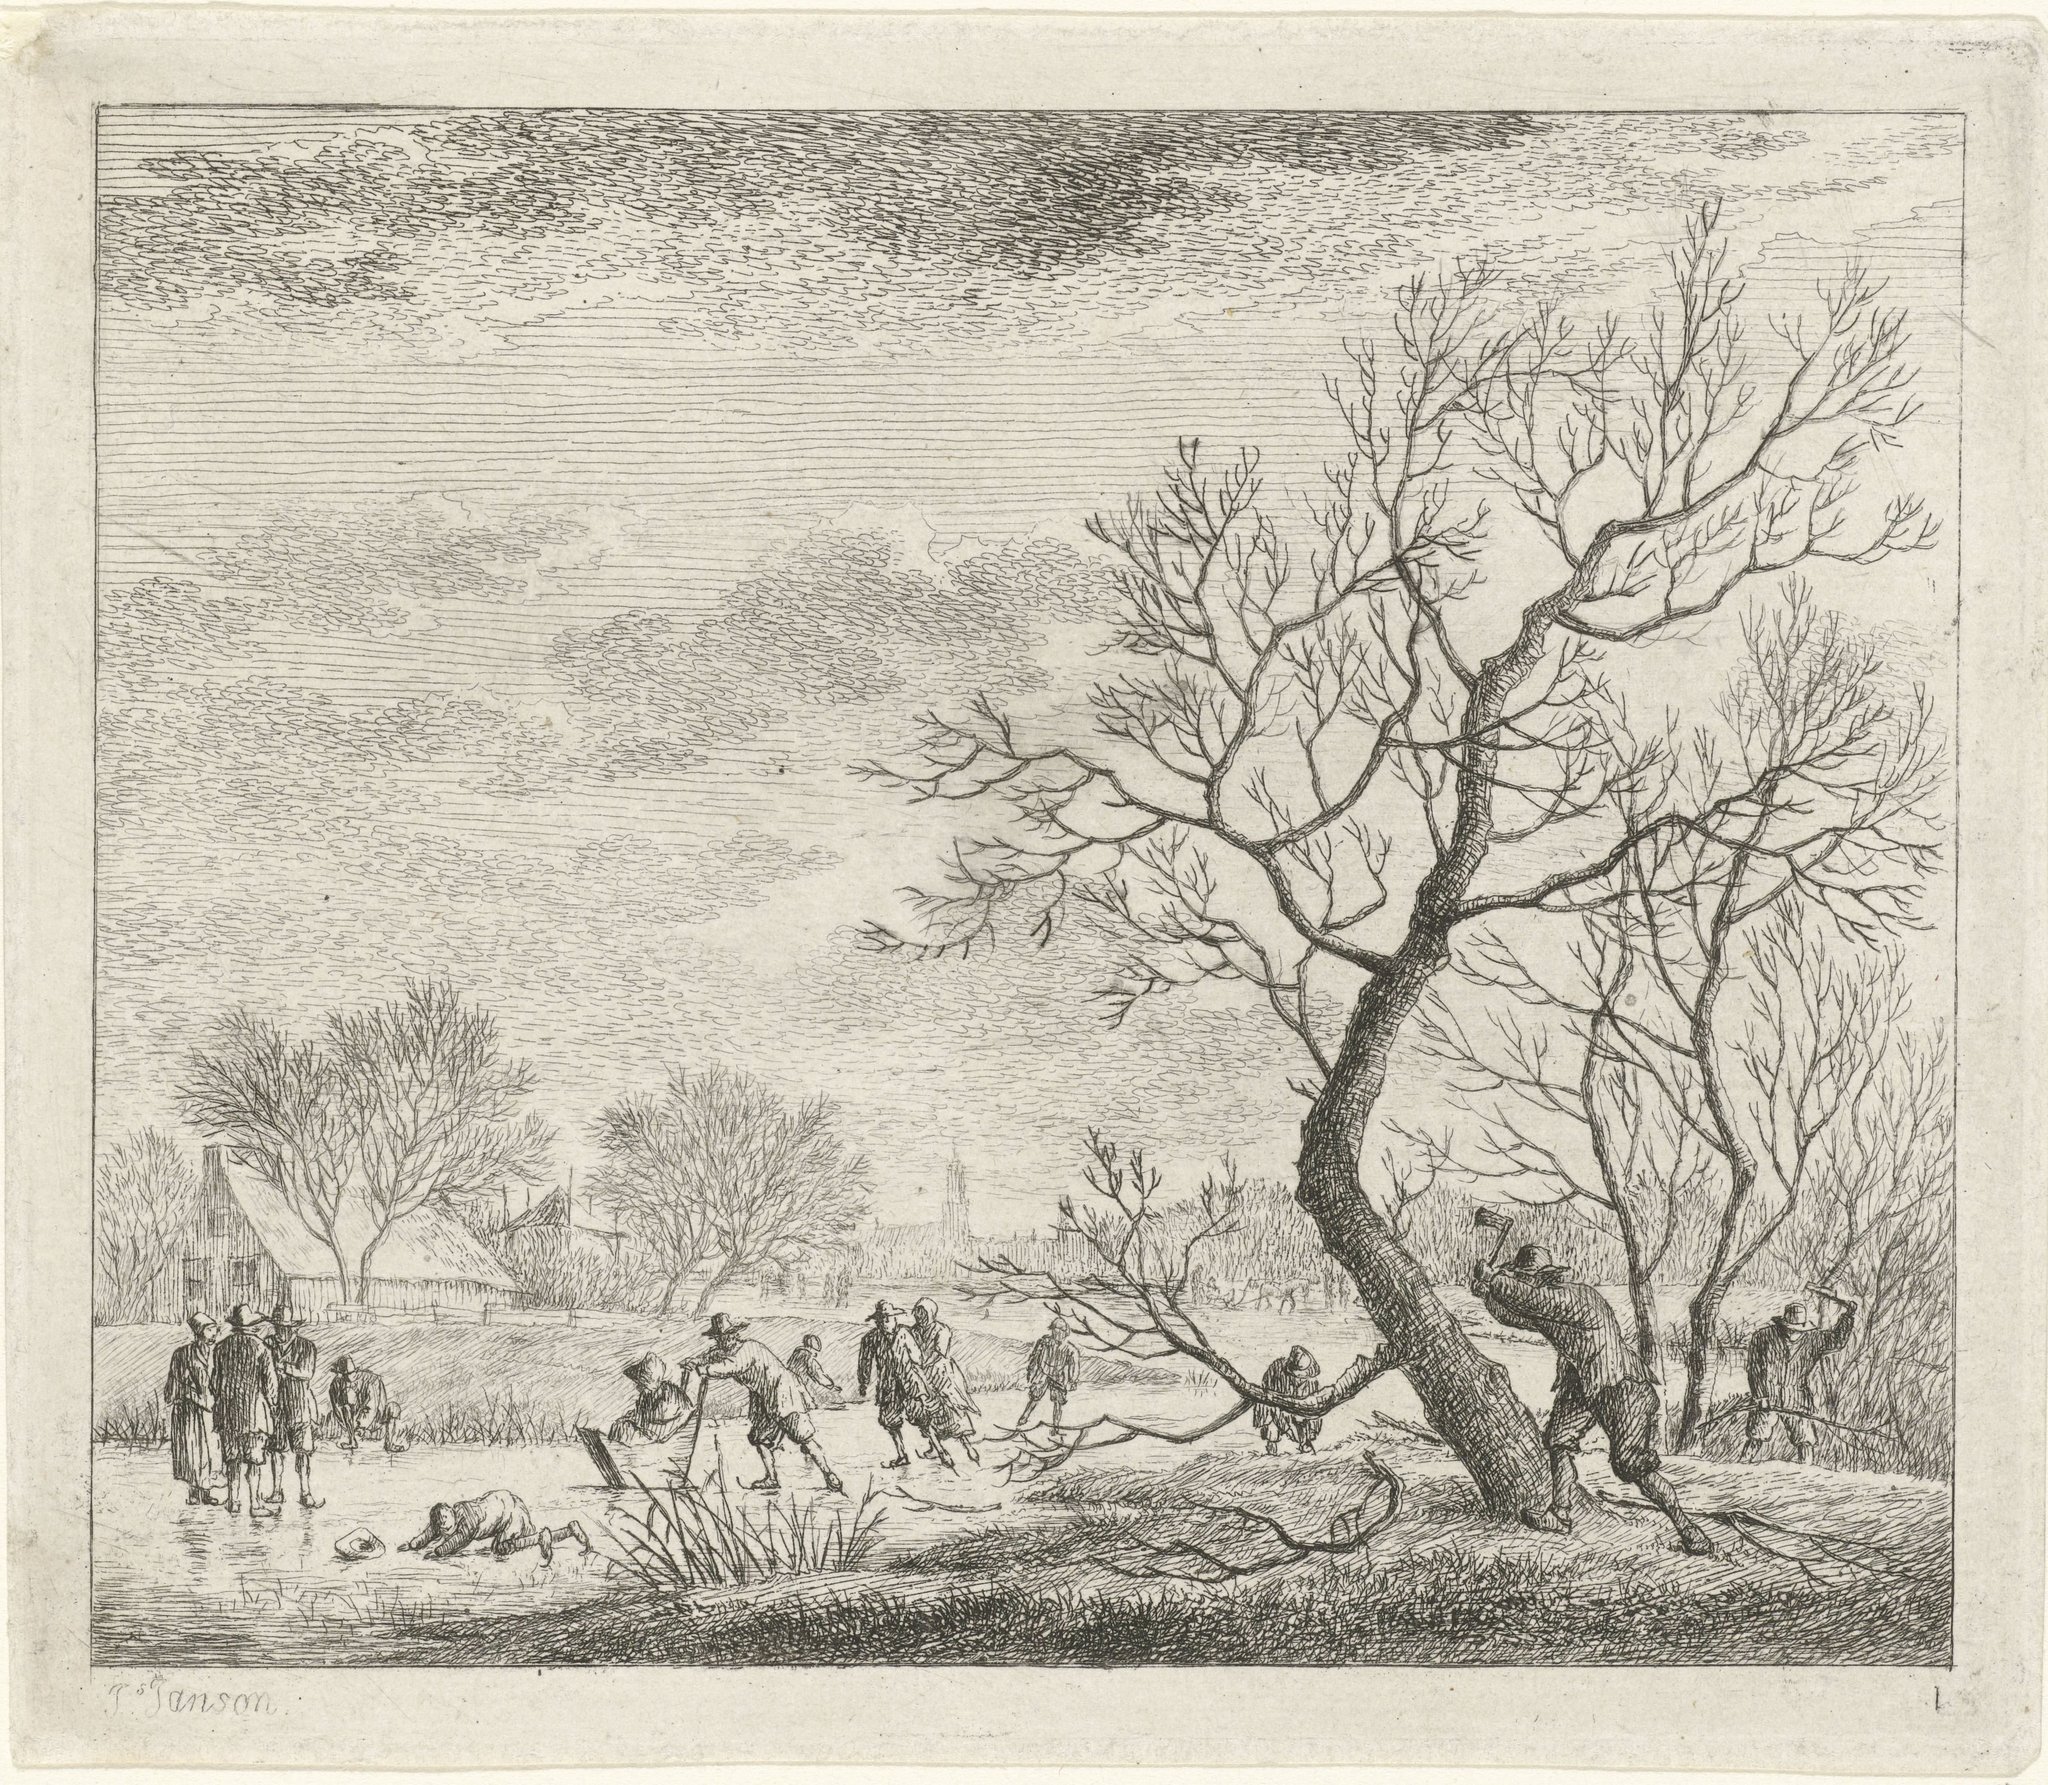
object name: print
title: Januari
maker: johannes janson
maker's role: draughtsman, painter, print maker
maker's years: 1729-1784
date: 1783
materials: paper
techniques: etching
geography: leiden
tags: winter landscape; landscape symbolizing winter (the four seasons of the year), landscape symbolizing january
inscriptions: collector's mark: Lugt 2228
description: Winterlandschap met schaatsers en rechts op de voorgrond een man met een bijl bij een boom. Op de achtergrond een dorp. Rechtsonder: 1. Tweede prent uit een serie van dertien met maanden.